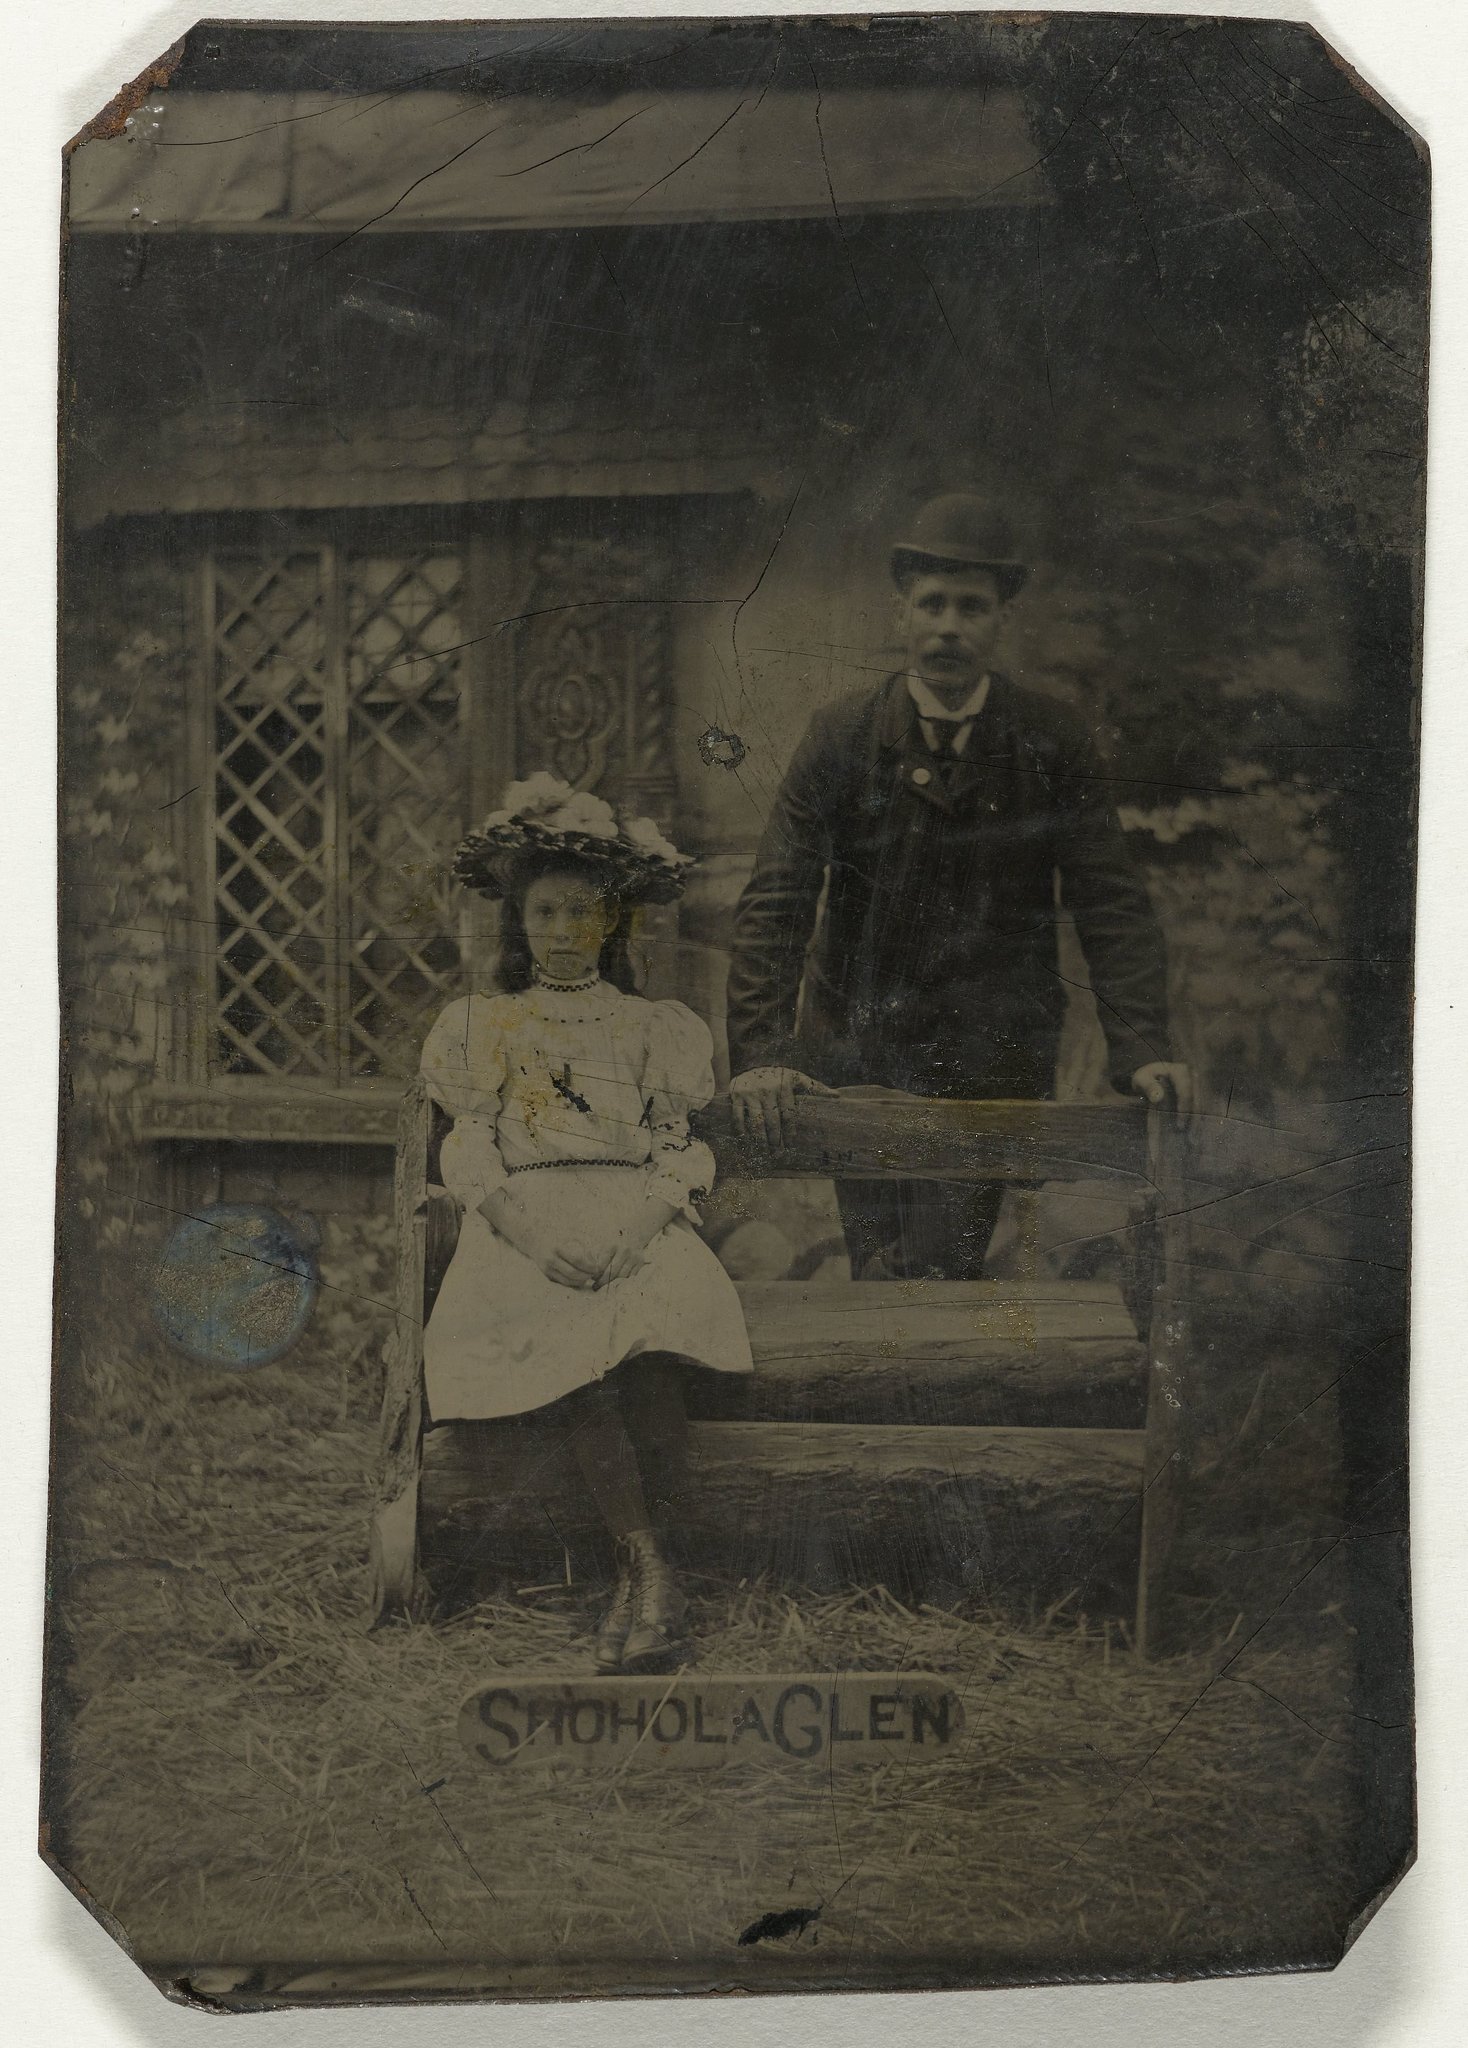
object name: photograph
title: Portret van een man en een meisje in het park Shohola Glen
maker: Anonymous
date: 1880-1900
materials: metal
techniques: ferrotyping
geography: shohola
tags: shohola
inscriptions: title: ‘SHOHOLA GLEN’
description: Portret van een man en een meisje, Vader en dochter?